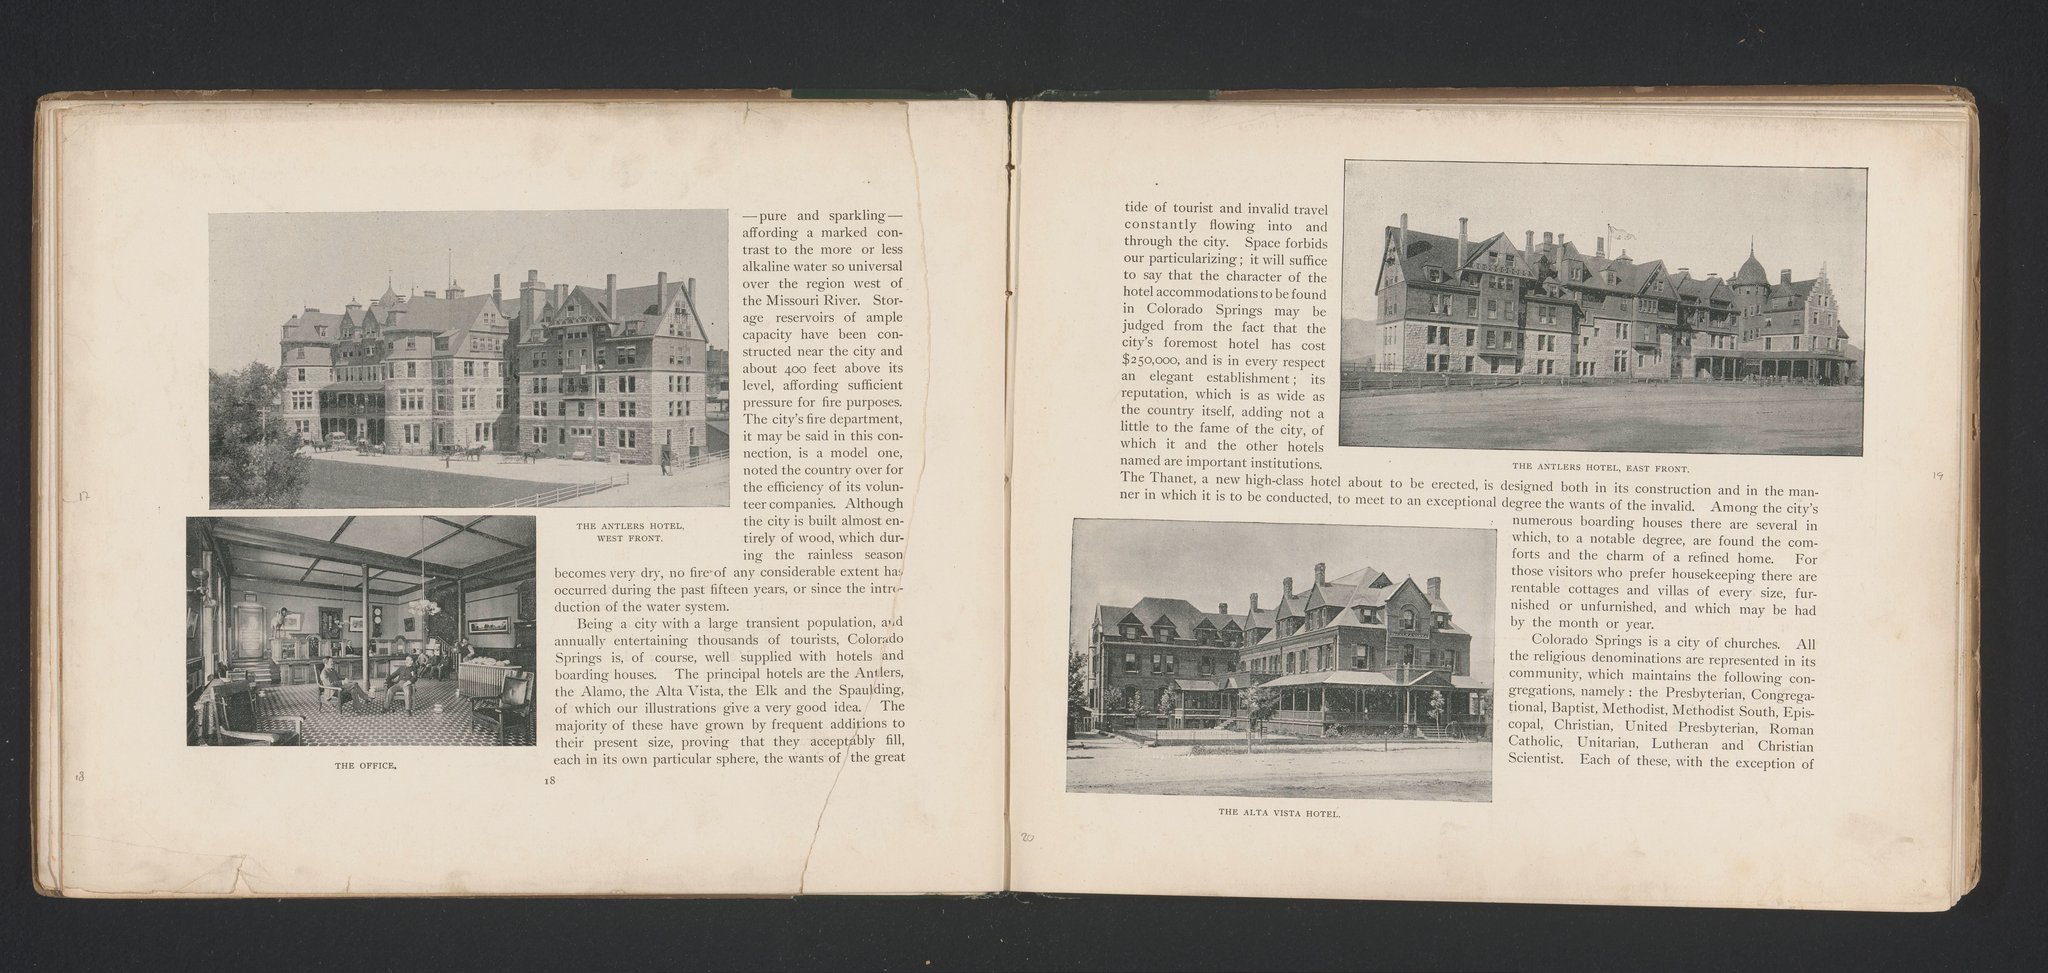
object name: page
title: The Antlers Hotel, West front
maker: Anonymous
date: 1888-1893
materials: paper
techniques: autotype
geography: new york city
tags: façade (of house or building), hotel, hostelry, inn